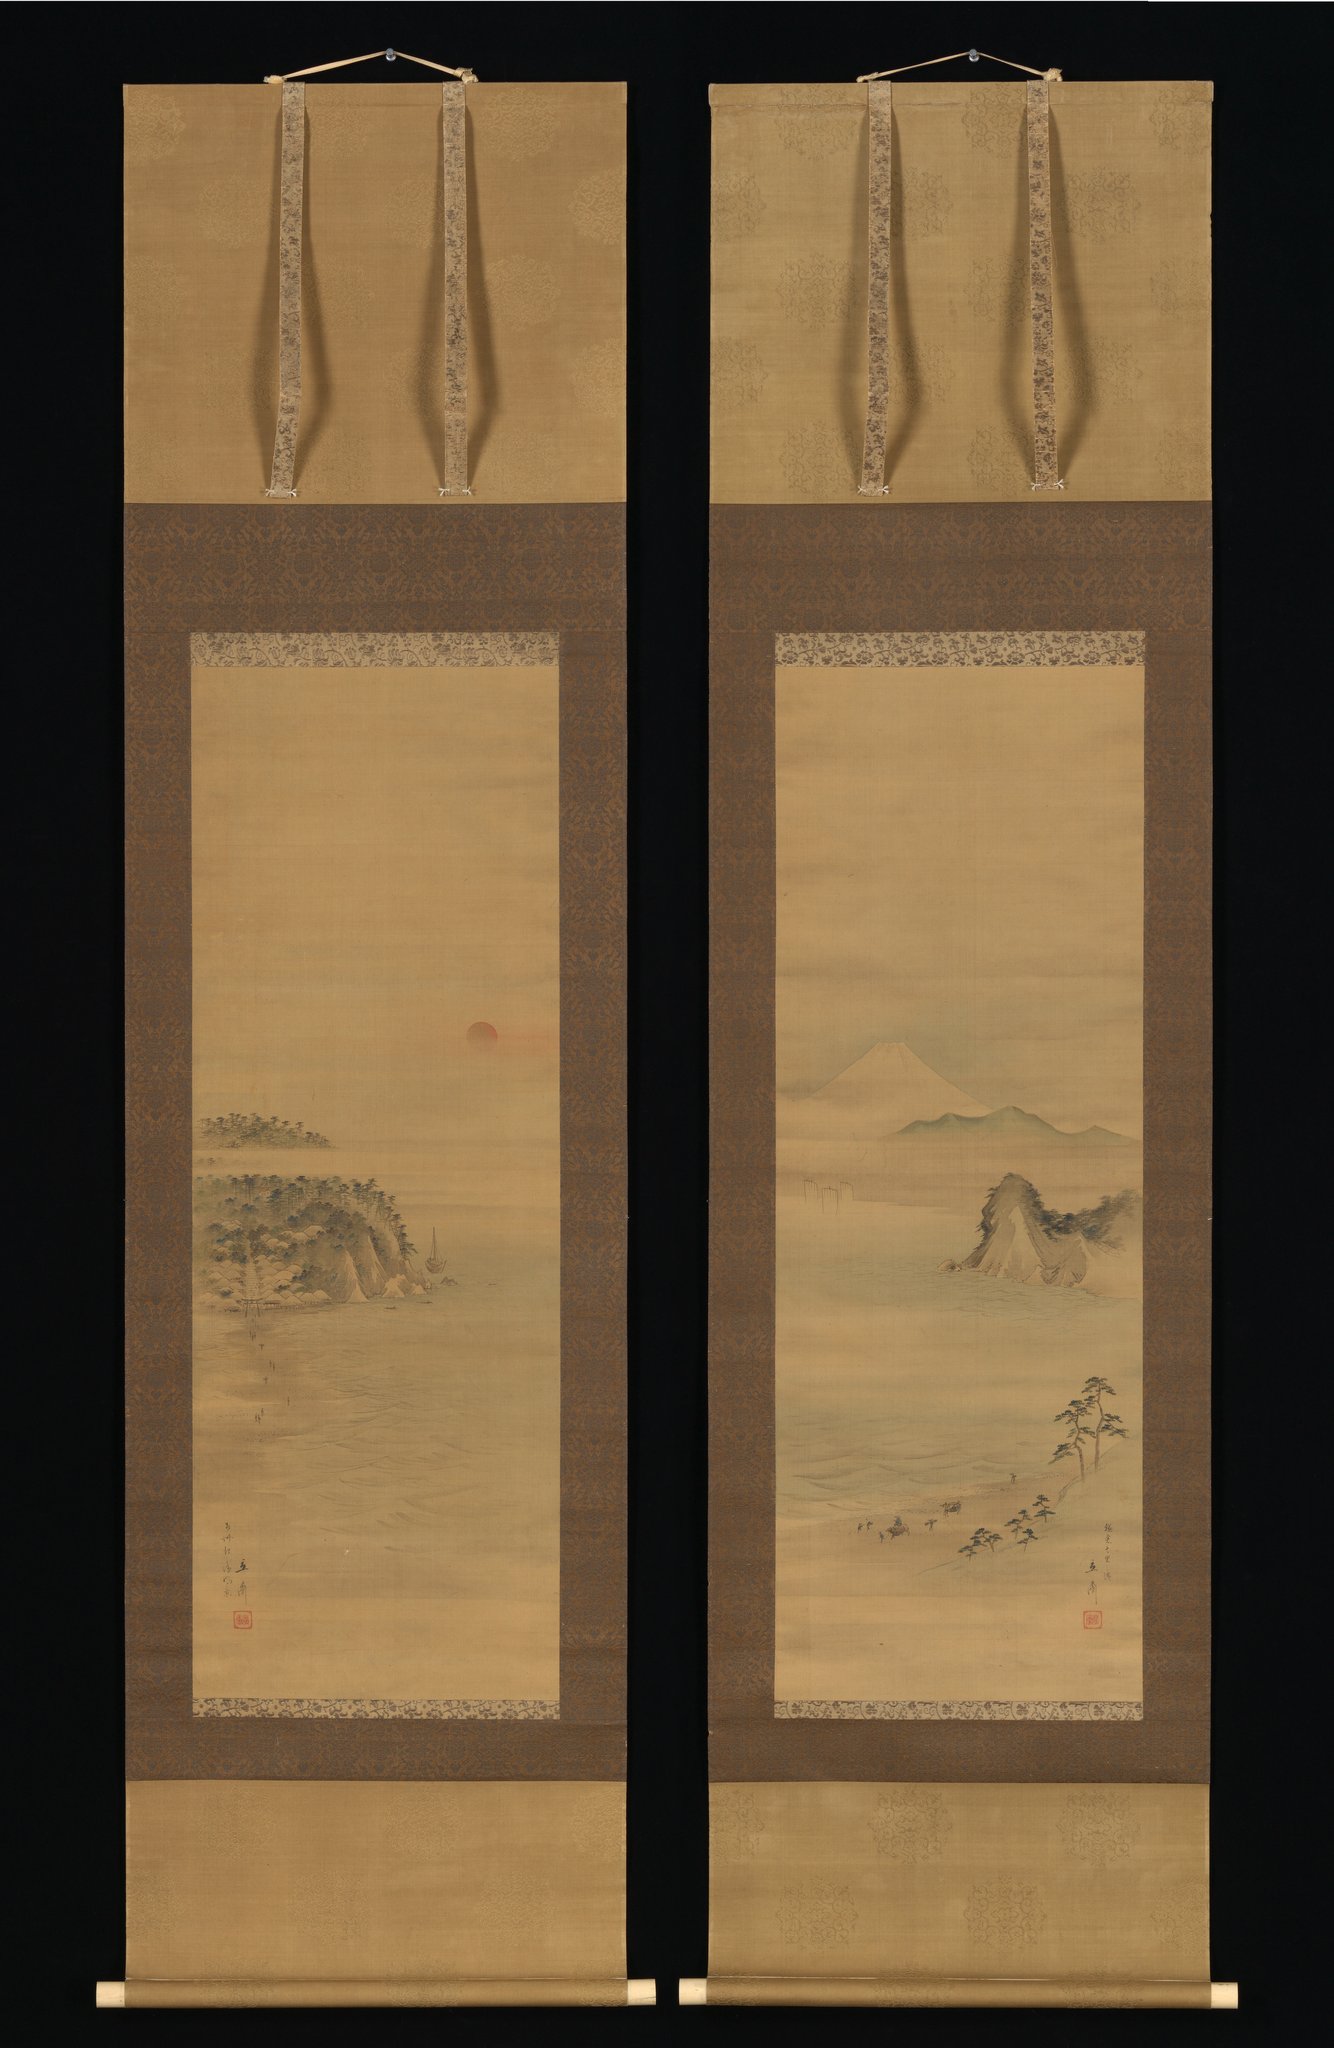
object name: hanging scroll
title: Shichirigahama and Enoshima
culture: japanese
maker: utagawa hiroshige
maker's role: artist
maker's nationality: japanese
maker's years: 1797-1858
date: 1848-1854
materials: ink, silk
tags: landscapes